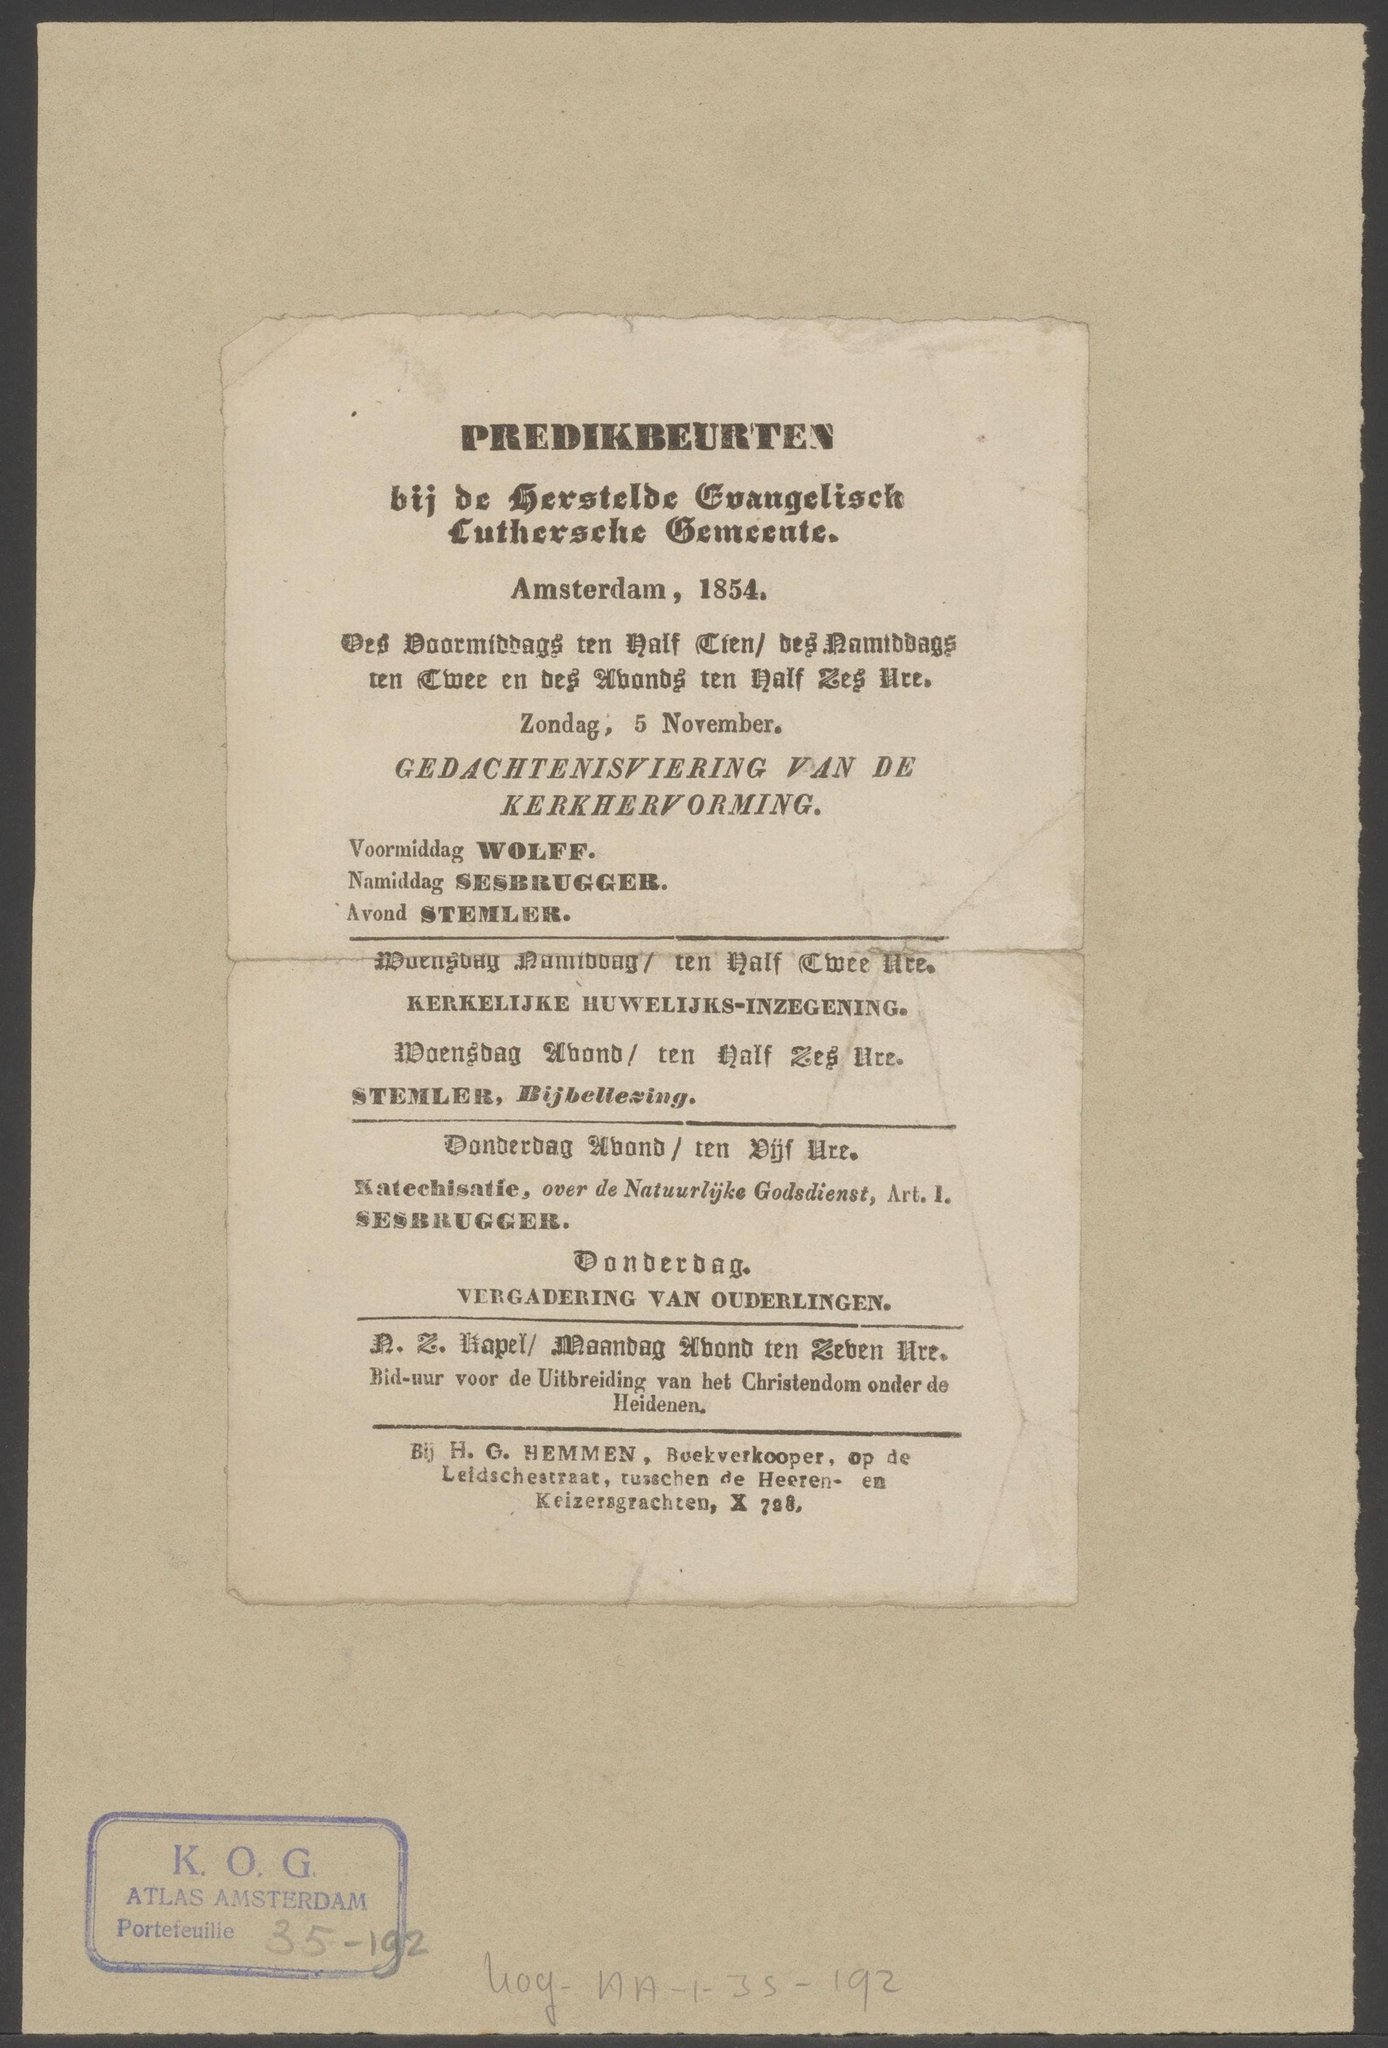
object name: text sheet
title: Predikbeurten bij de herstelde Evangelisch Luthersche Gemeente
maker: Anonymous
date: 1854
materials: paper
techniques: letterpress printing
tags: hersteld evangelisch-lutherse kerk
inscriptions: collector's mark: Lugt 1641b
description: Onderwerpsrubriek binnen de Atlas Amsterdam: Kerkwezen: Ev. Lutherse Gemeente: Herst. Ev. Luth. Gemeente.